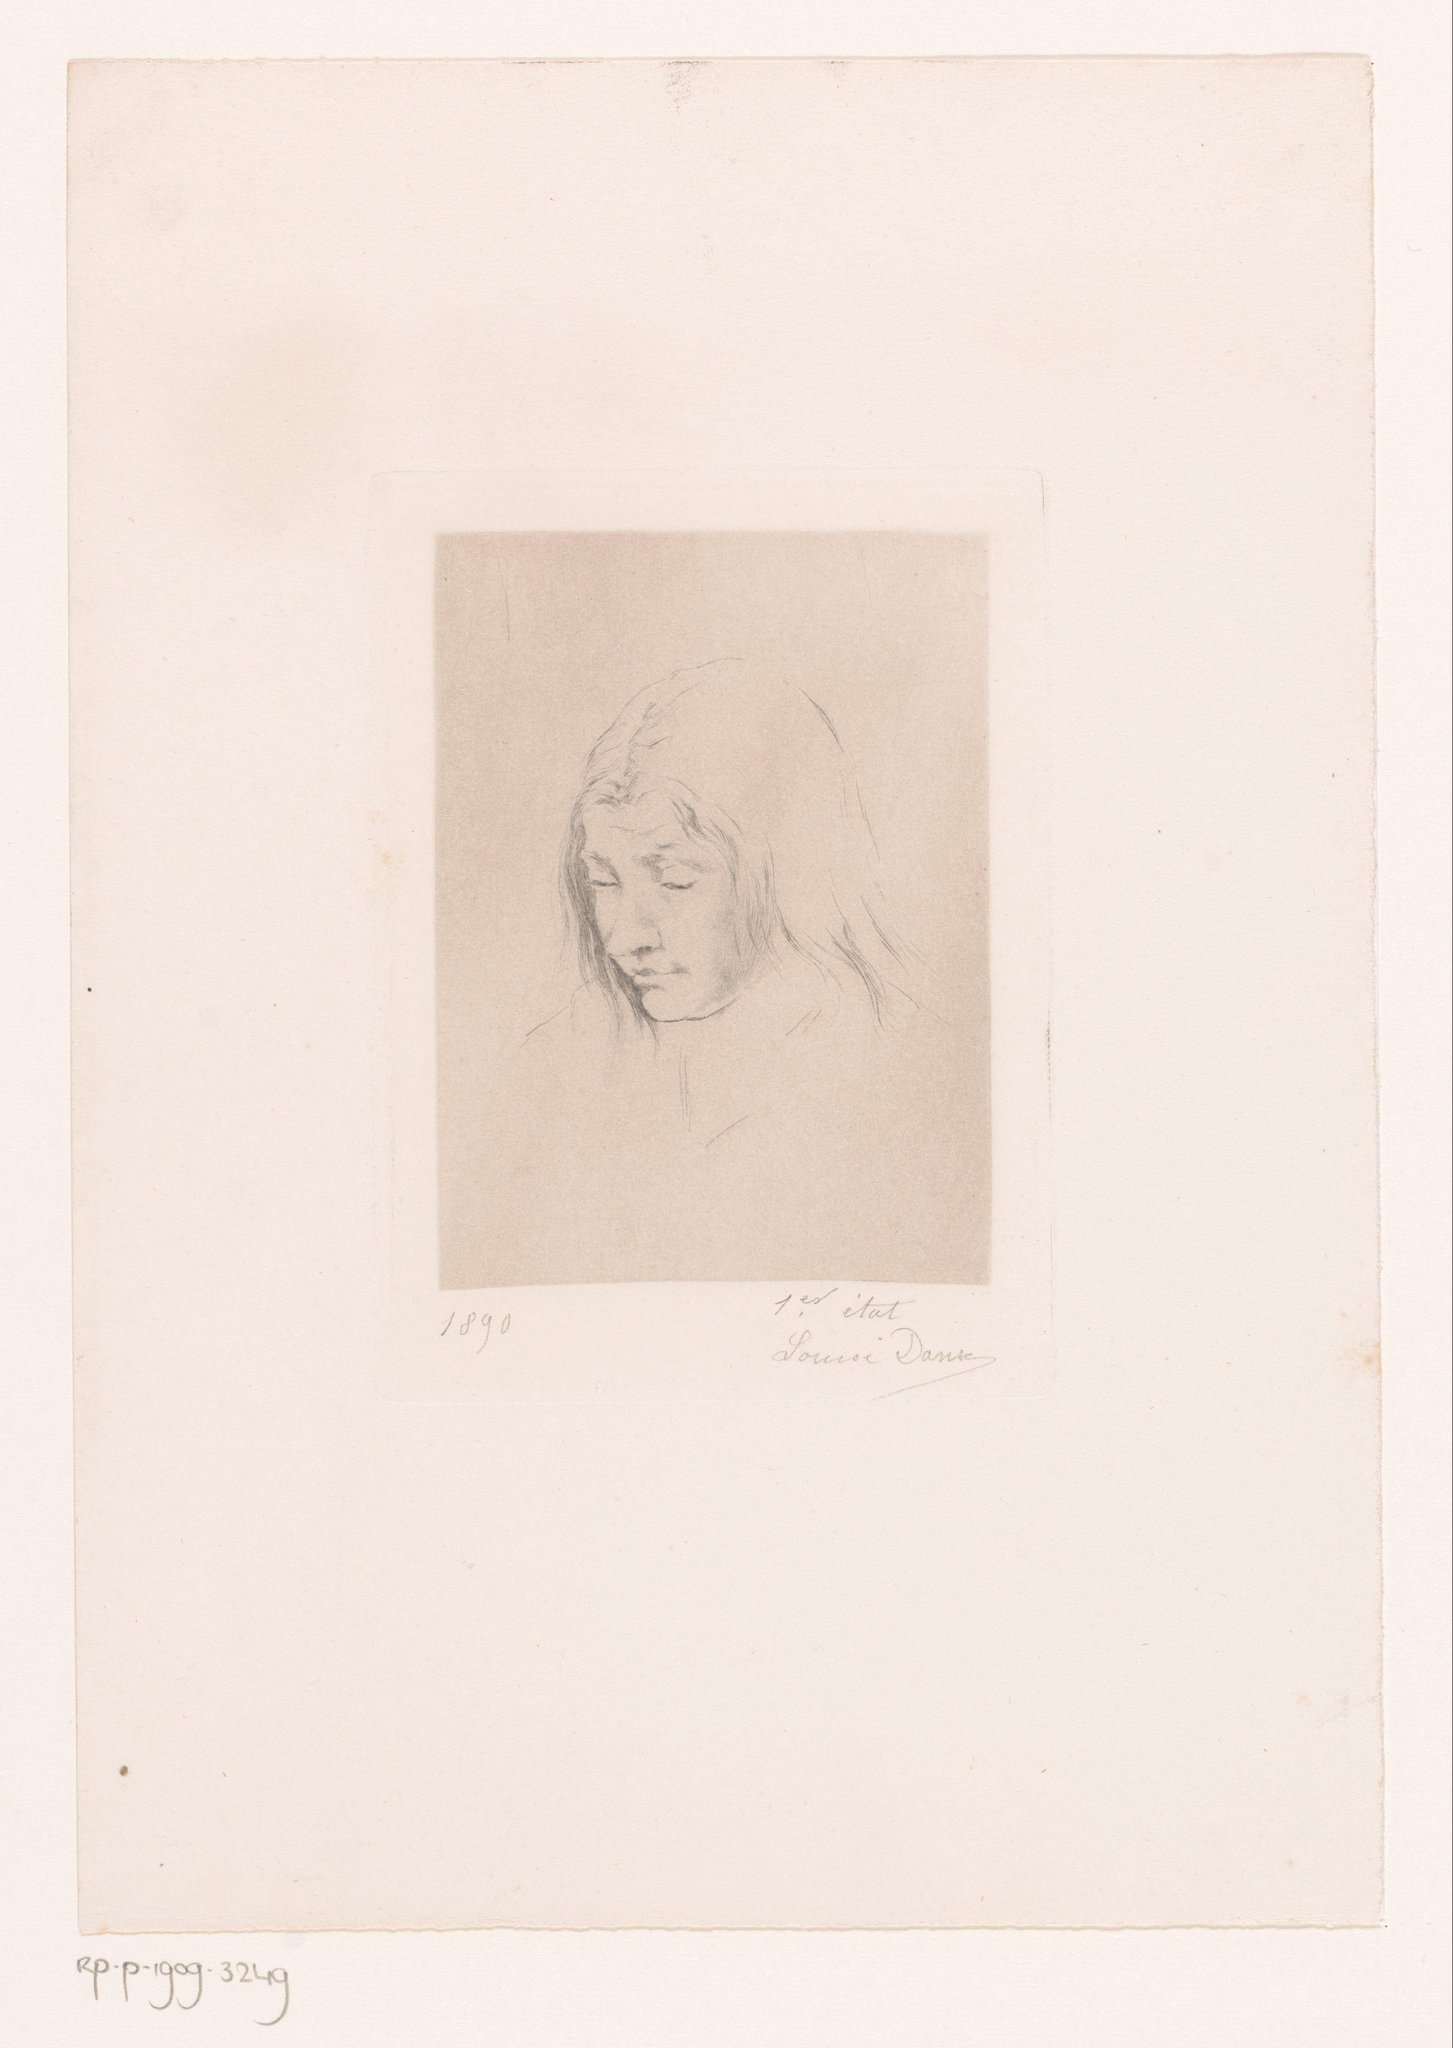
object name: print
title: Folle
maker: louise danse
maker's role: painter, print maker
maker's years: 1867-1948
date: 1890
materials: paper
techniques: etching, intaglio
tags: anonymous historical person portrayed alone - bb - woman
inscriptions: annotation: ‘1er état’, collector's mark: Lugt 2228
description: Ondanks de annotatie "1er état" (eerste staat), lijkt dit een iets gewijzigde staat van RP-P-1909-3248, die tevens het opschrift "1er état" heeft.